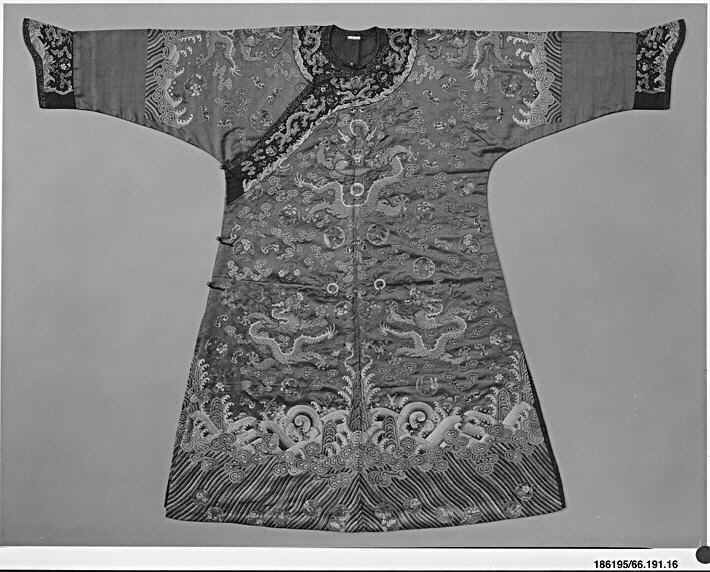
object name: robe, imperial court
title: Imperial Court Robe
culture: chinese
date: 1796-1820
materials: metal thread, silk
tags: dragons